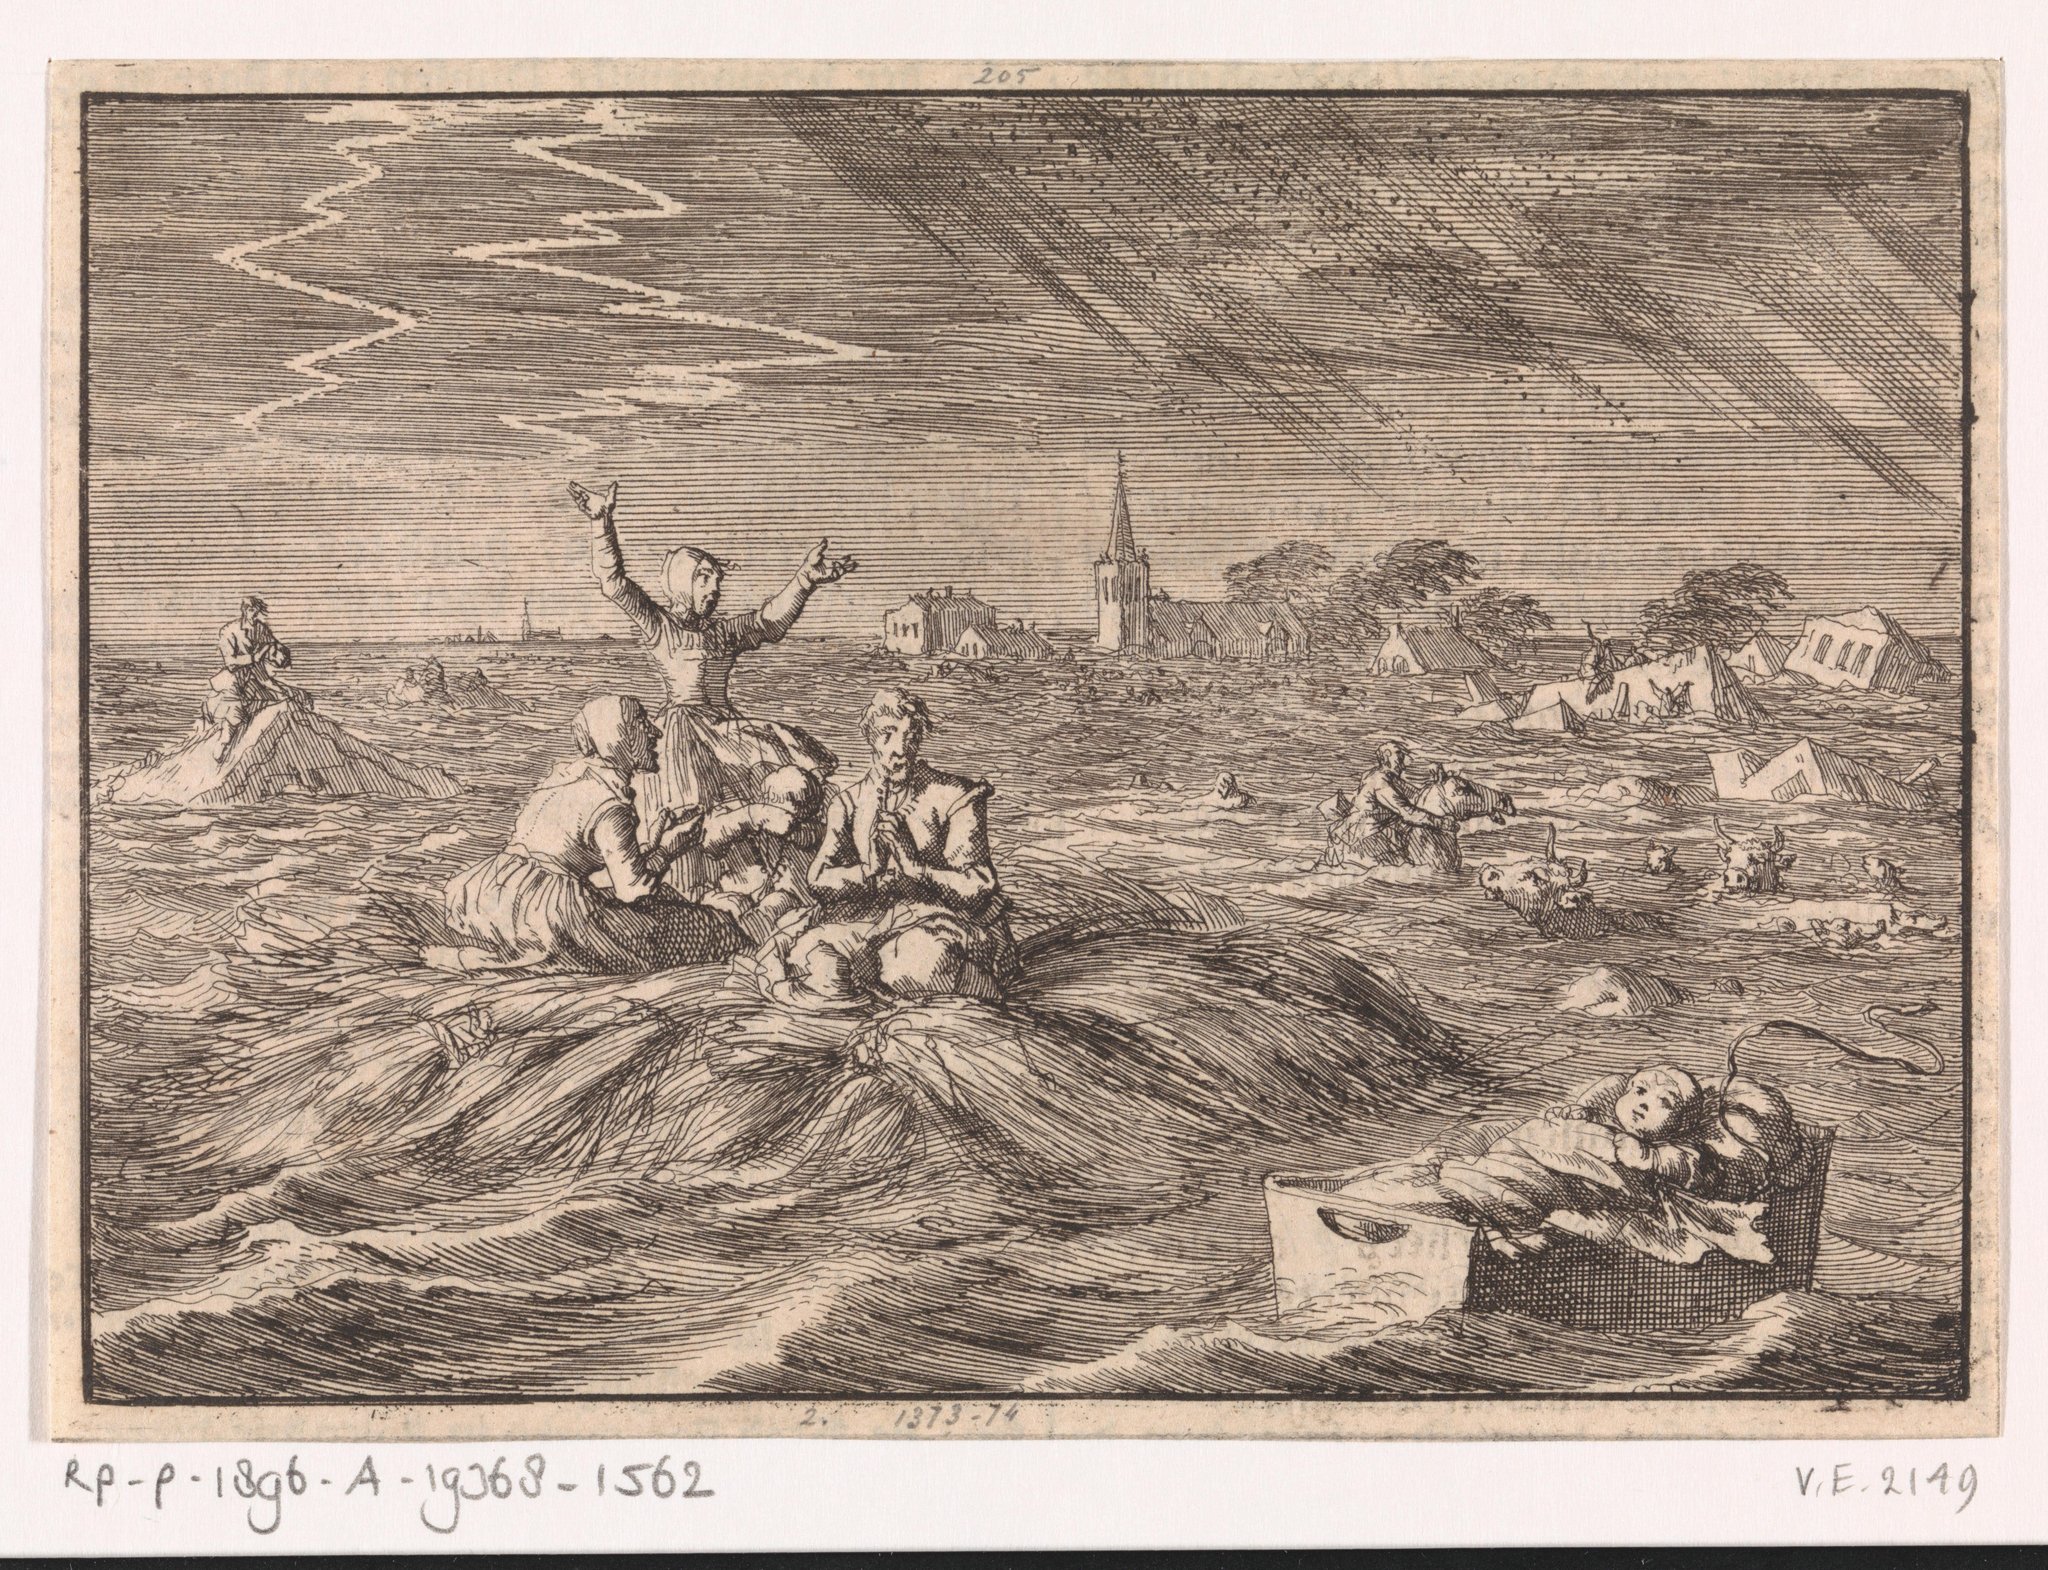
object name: book illustration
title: Watersnood in Groningen, 1686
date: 1698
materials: paper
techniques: etching, letterpress printing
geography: amsterdam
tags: flood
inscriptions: collector's mark: Lugt 2228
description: Illustratie uit: Gottfried, Johann Ludwig. Historische kronyck; vervattende een (...) beschrijvingh der aldergedenckwaerdigste geschiedenissen des weerelds, van den aenvangh der scheppingh tot (...) 1576 (2 delen). Leiden: Pieter van der Aa, 1698, dl. II, p. 1373.